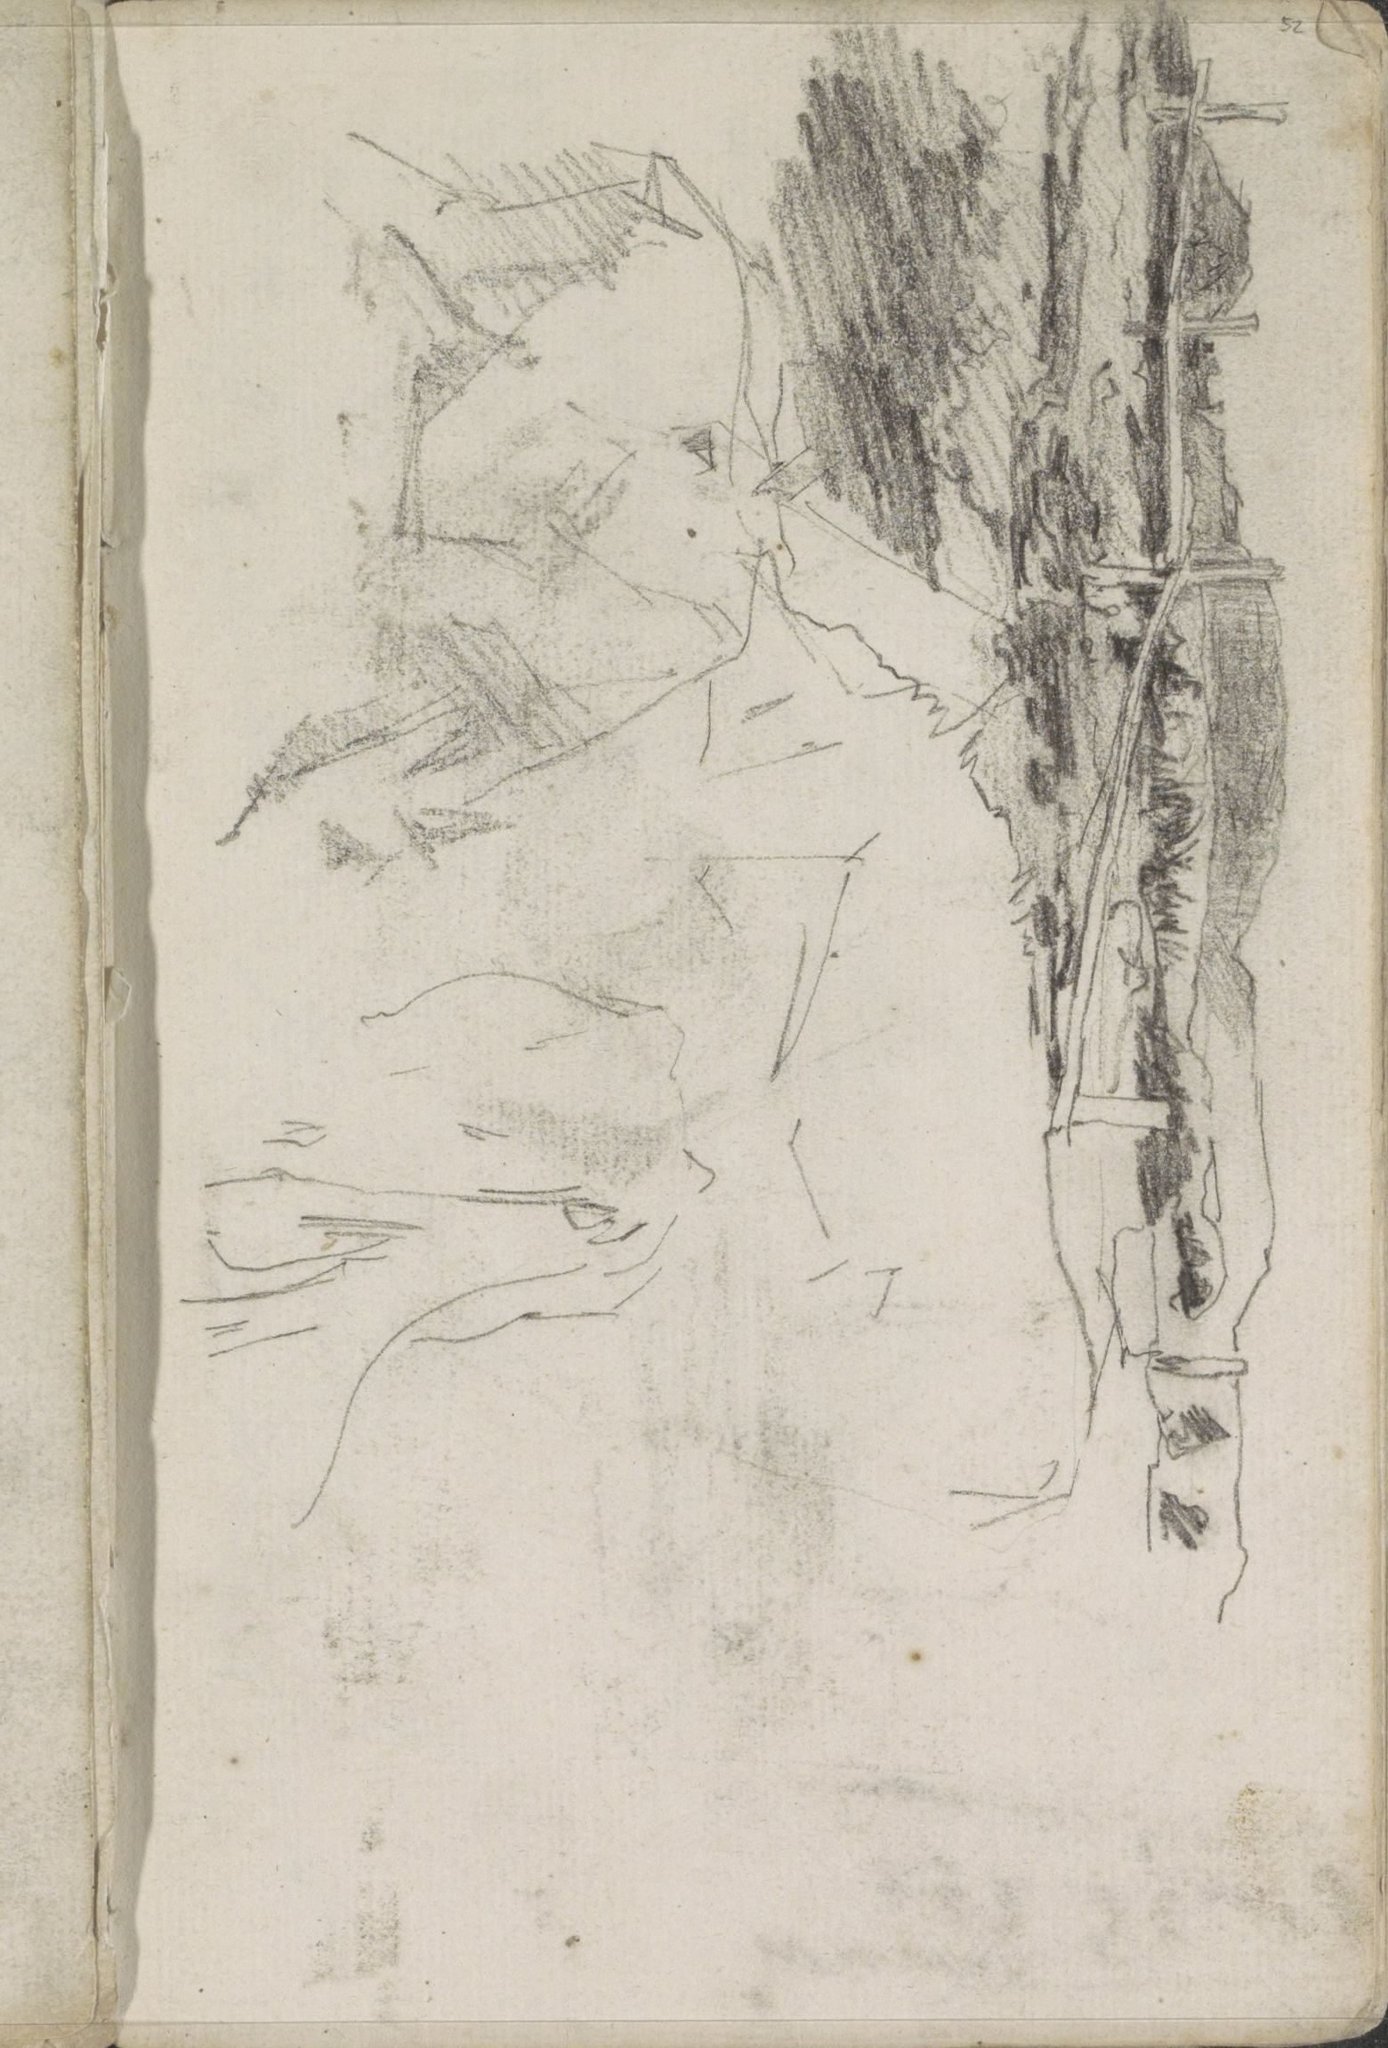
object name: sketchbook leaf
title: Landschap en grazende koeien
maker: george hendrik breitner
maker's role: draughtsman, painter, print maker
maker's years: 1857-1923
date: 1880-1882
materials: chalk, paper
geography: the hague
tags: cow, landscapes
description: Pagina 52 uit een schetsboek met 29 bladen.